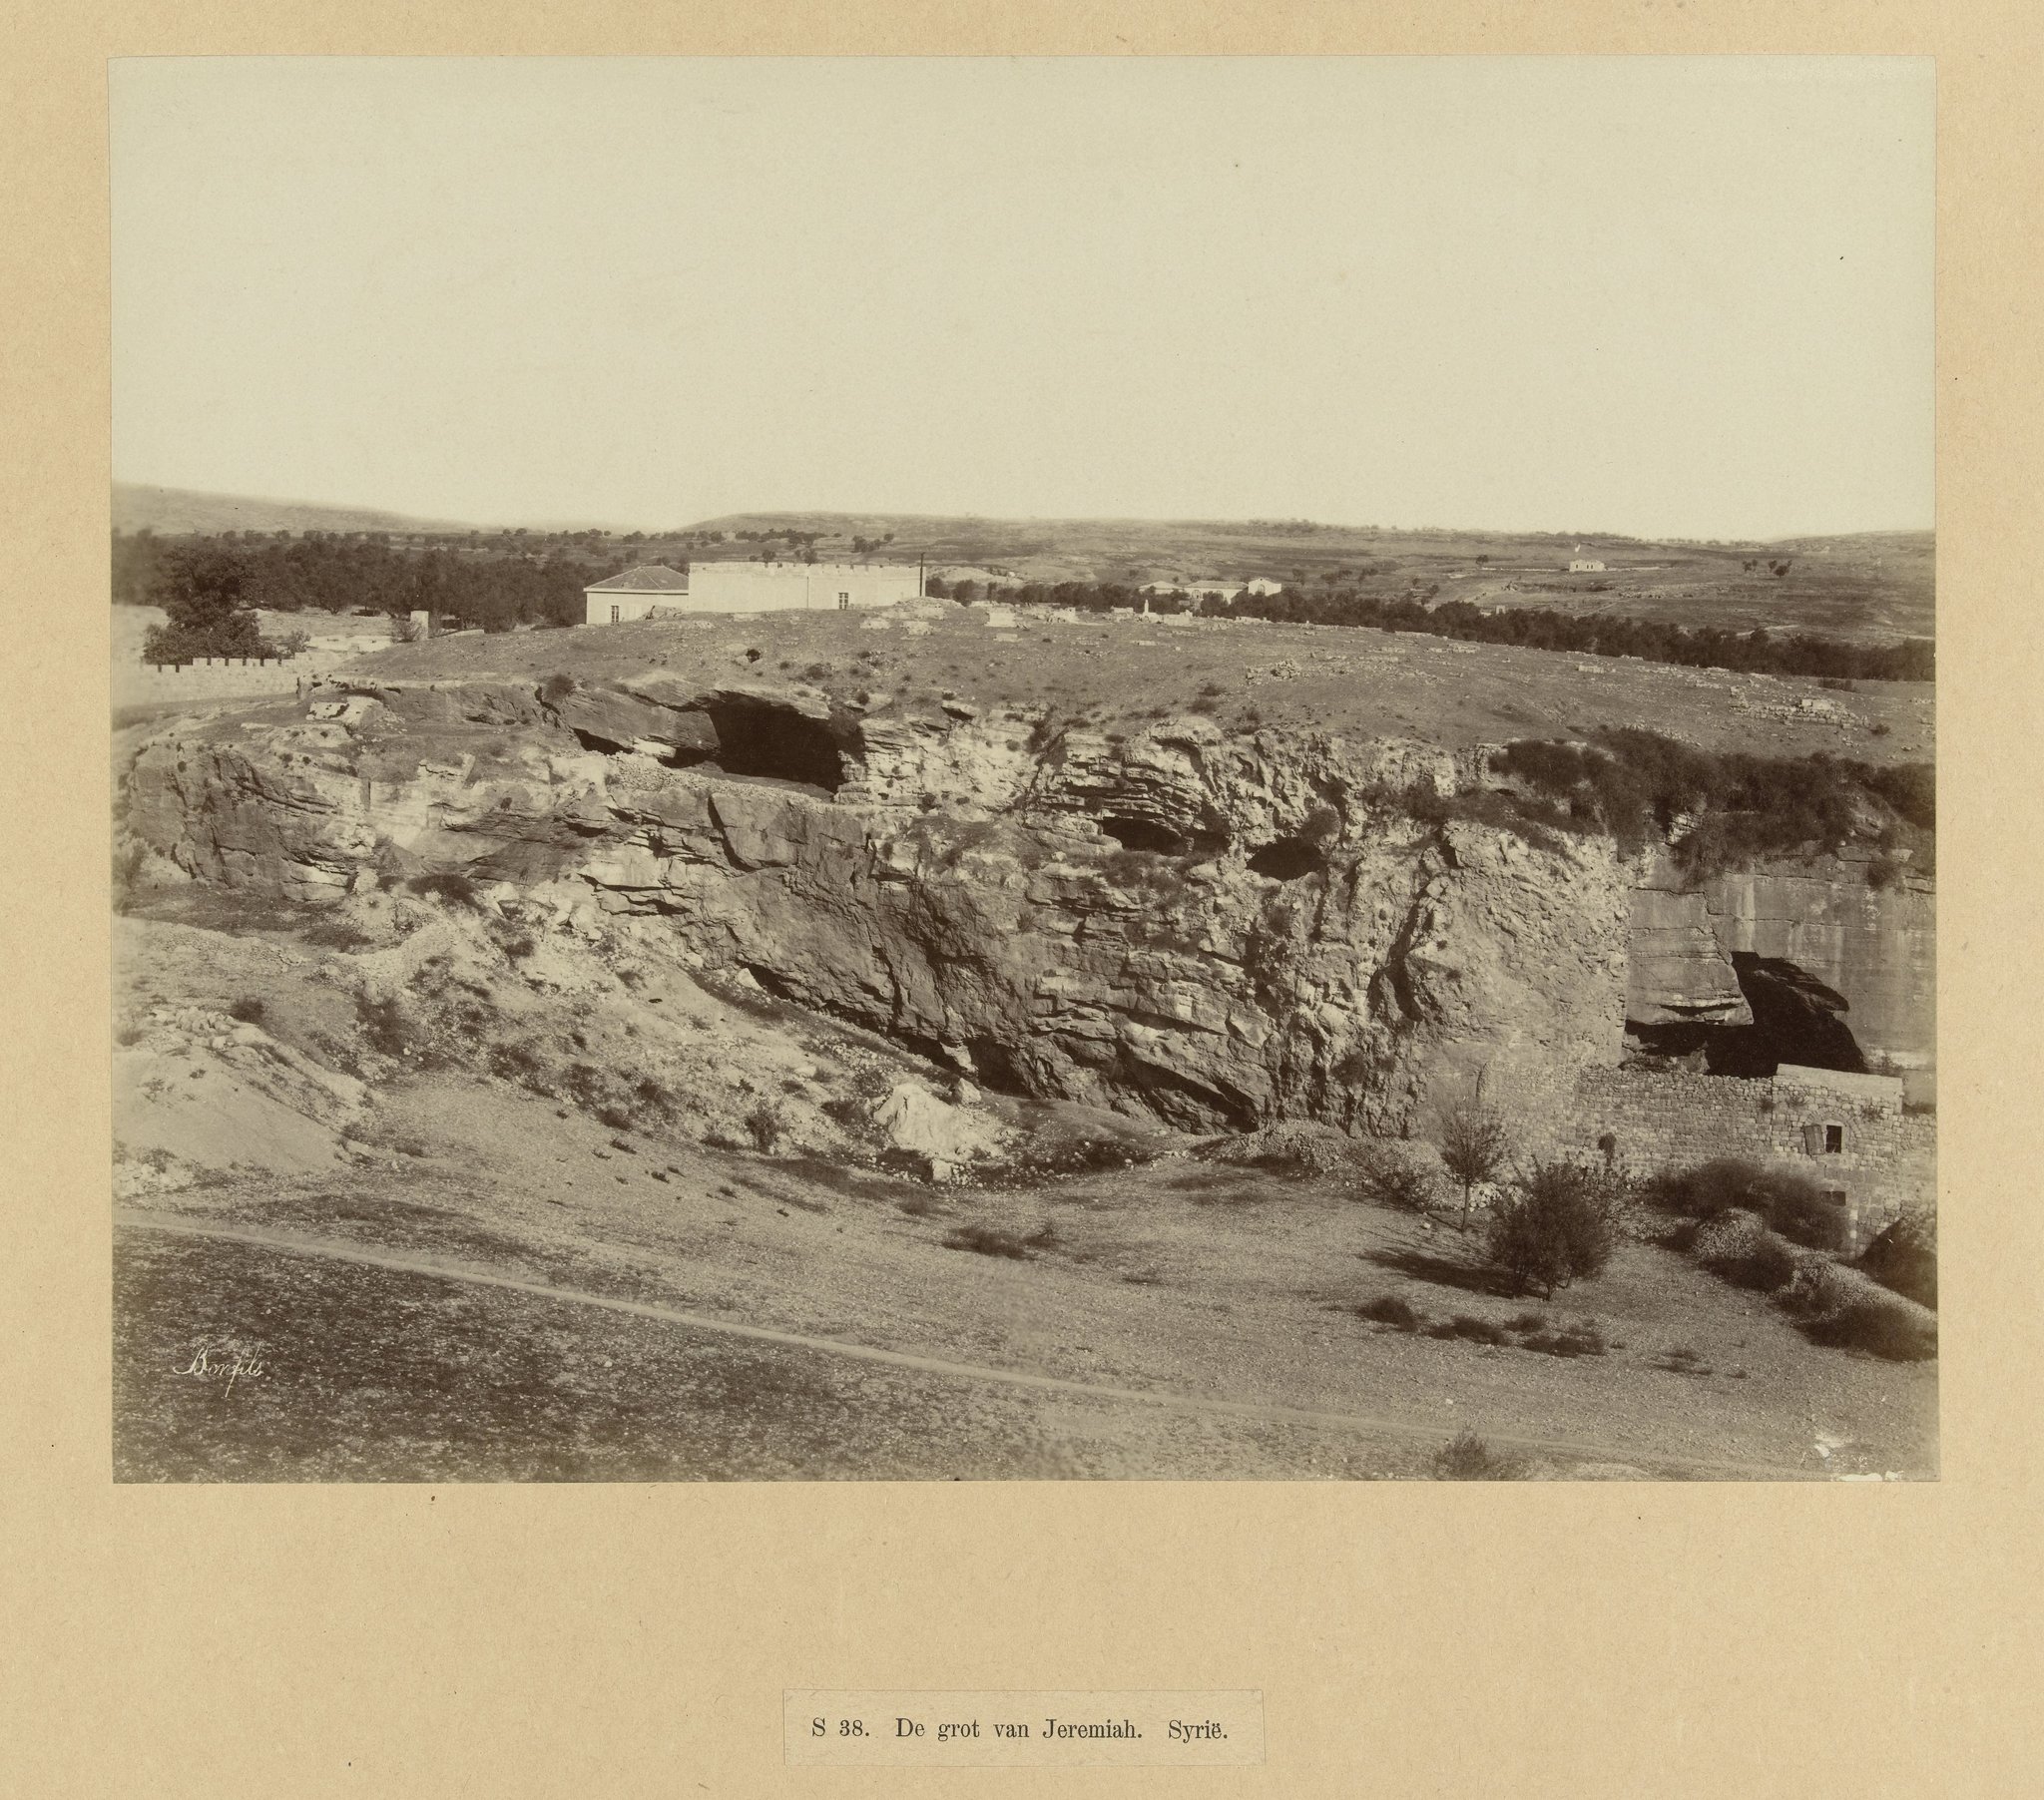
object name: photograph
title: Gezicht op de grot van Sedekia, Jeruzalem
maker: félix bonfils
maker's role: fotograaf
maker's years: 1831-1885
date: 1867-1877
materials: cardboard, paper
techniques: albumen print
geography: jerusalem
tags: cave, grotto, rock-formations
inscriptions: stamp: ‘Gemeentelijke bibliotheek/ Rotterdam’, title: ‘S 38. De grot van Jeremiah. Syrië.’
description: Onderdeel van een groep door fotograaf Richard Polak op reis verzamelde foto’s. Deze foto is samen met andere op zijn reizen verzamelde foto's tentoongesteld bij de Rotterdamsche Kunstkring (1895), Arti en Amicitiae te Amsterdam (1897-1898?) en Societeit 't Collegie te Kampen (datum vooralsnog onbekend).